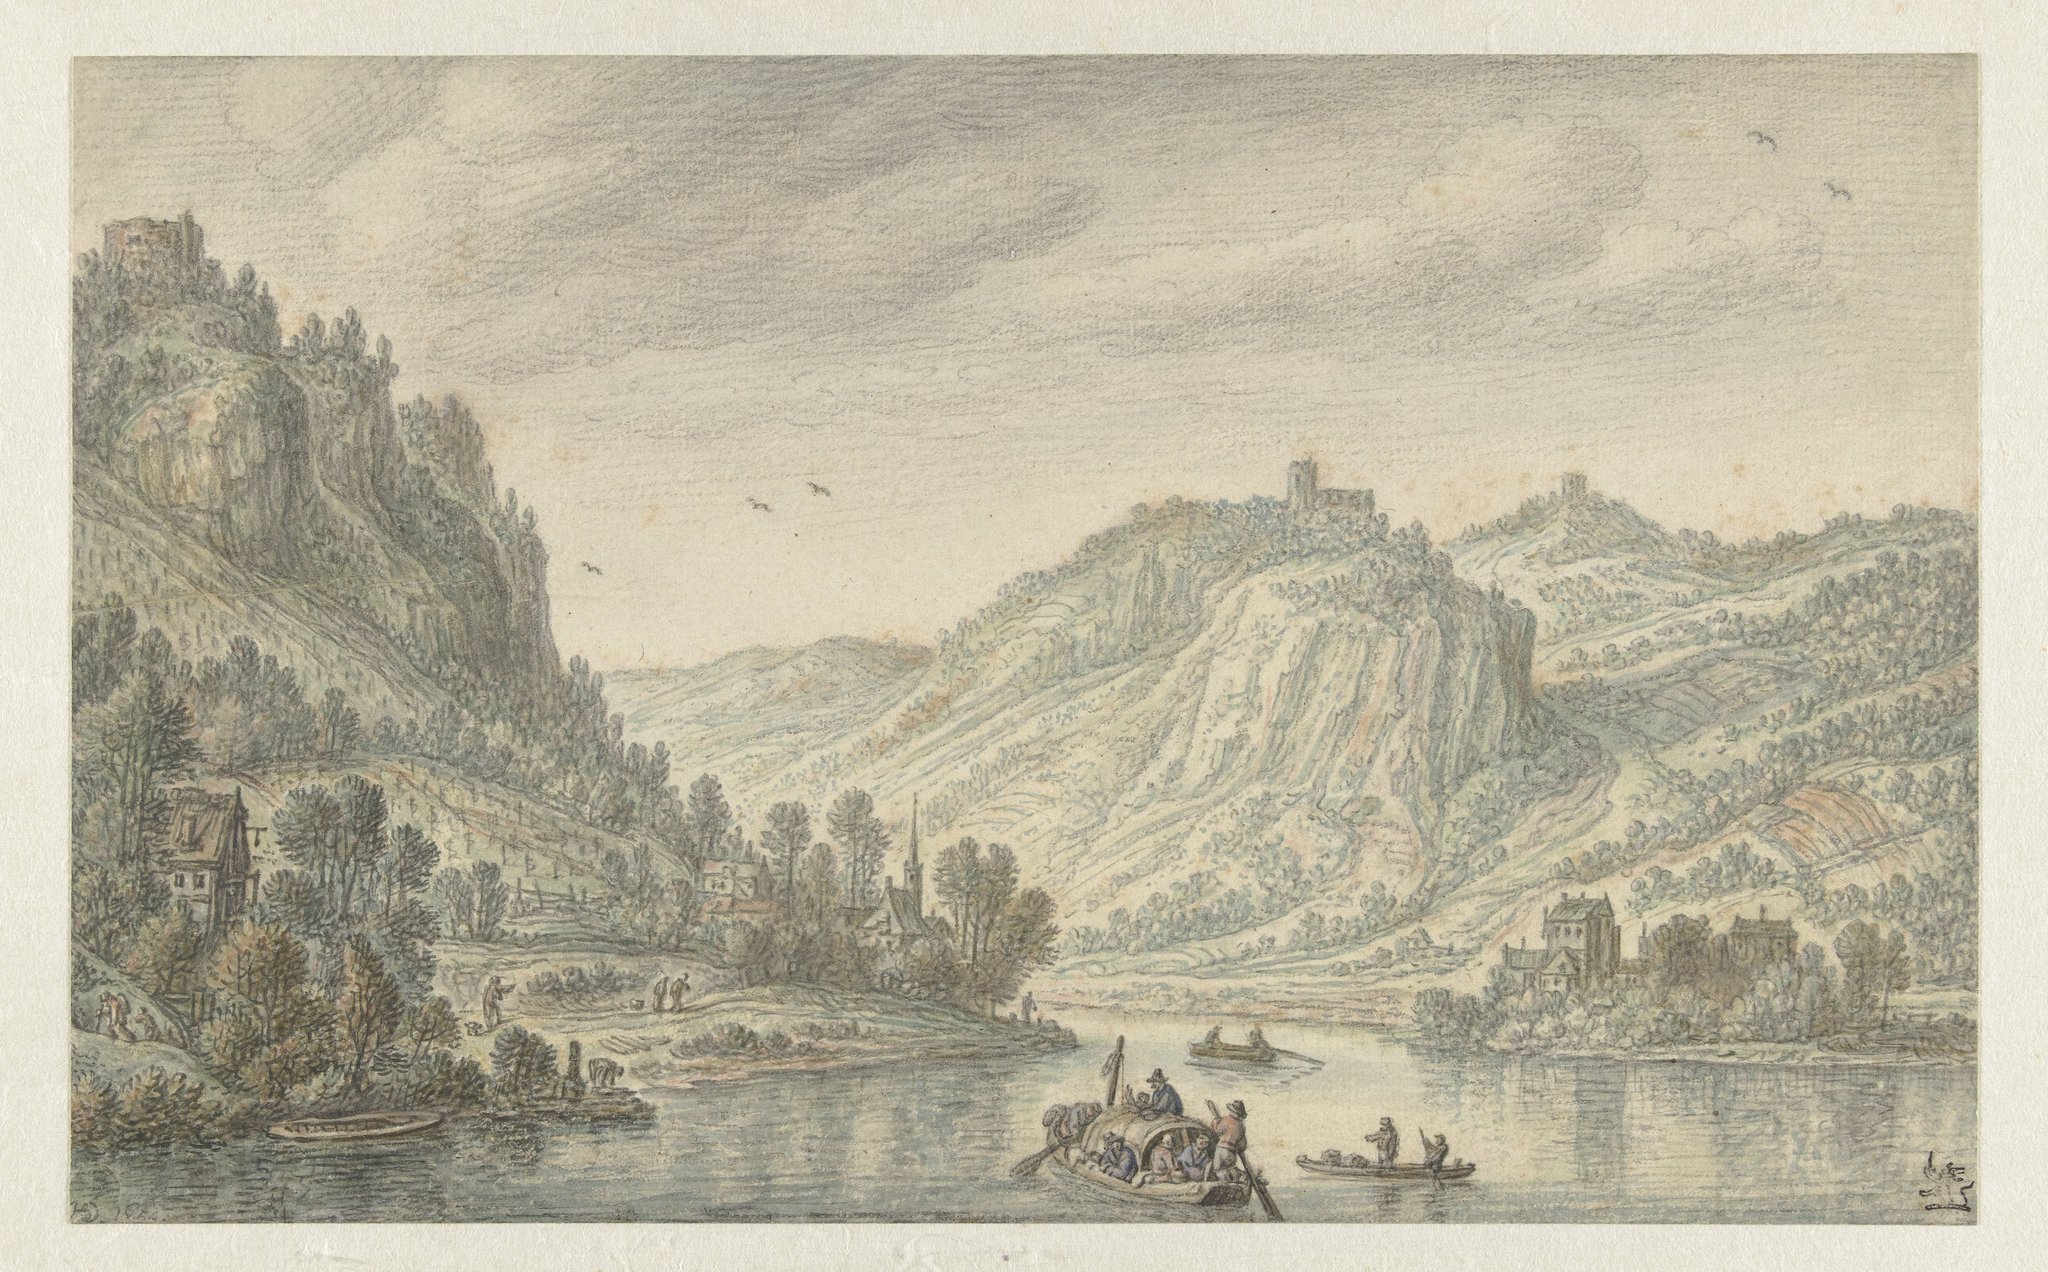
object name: drawing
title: Rijn bij de Drachenfels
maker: herman saftleven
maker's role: draughtsman, painter, print maker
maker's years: 1609-1685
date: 1670-1679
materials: chalk, paper, watercolor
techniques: brush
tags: river bank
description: Rijnlandschap met links Rolandseck en rechts Drachenfels.